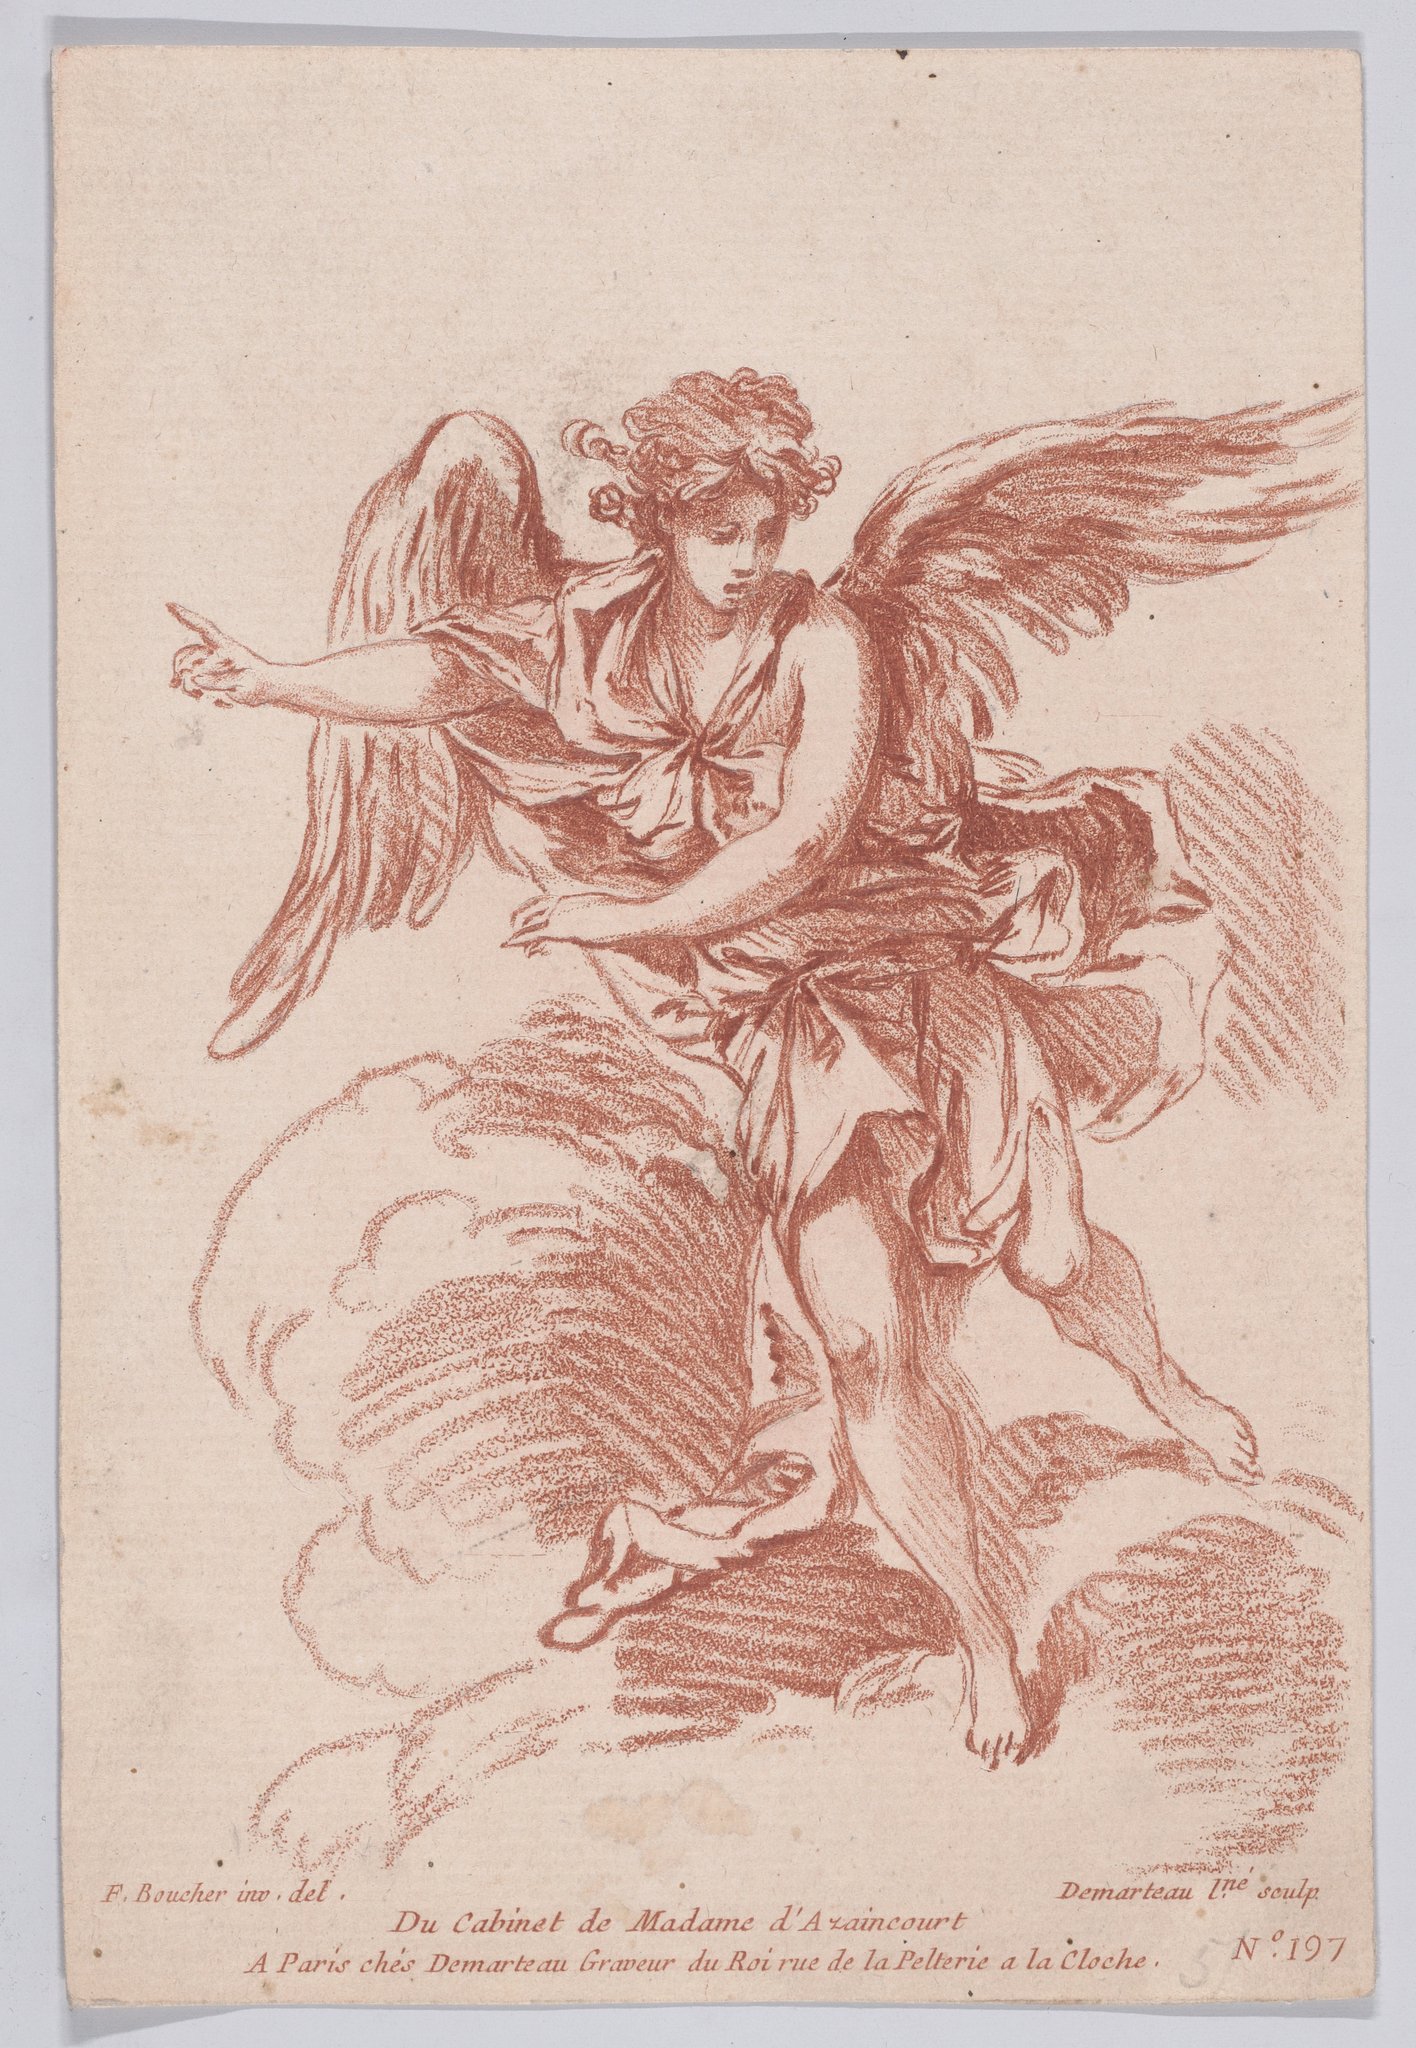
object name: print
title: Ange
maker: gilles demarteau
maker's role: artist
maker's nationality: french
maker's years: 1722-1776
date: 1701-1800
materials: ink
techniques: printmaking, etching, printing